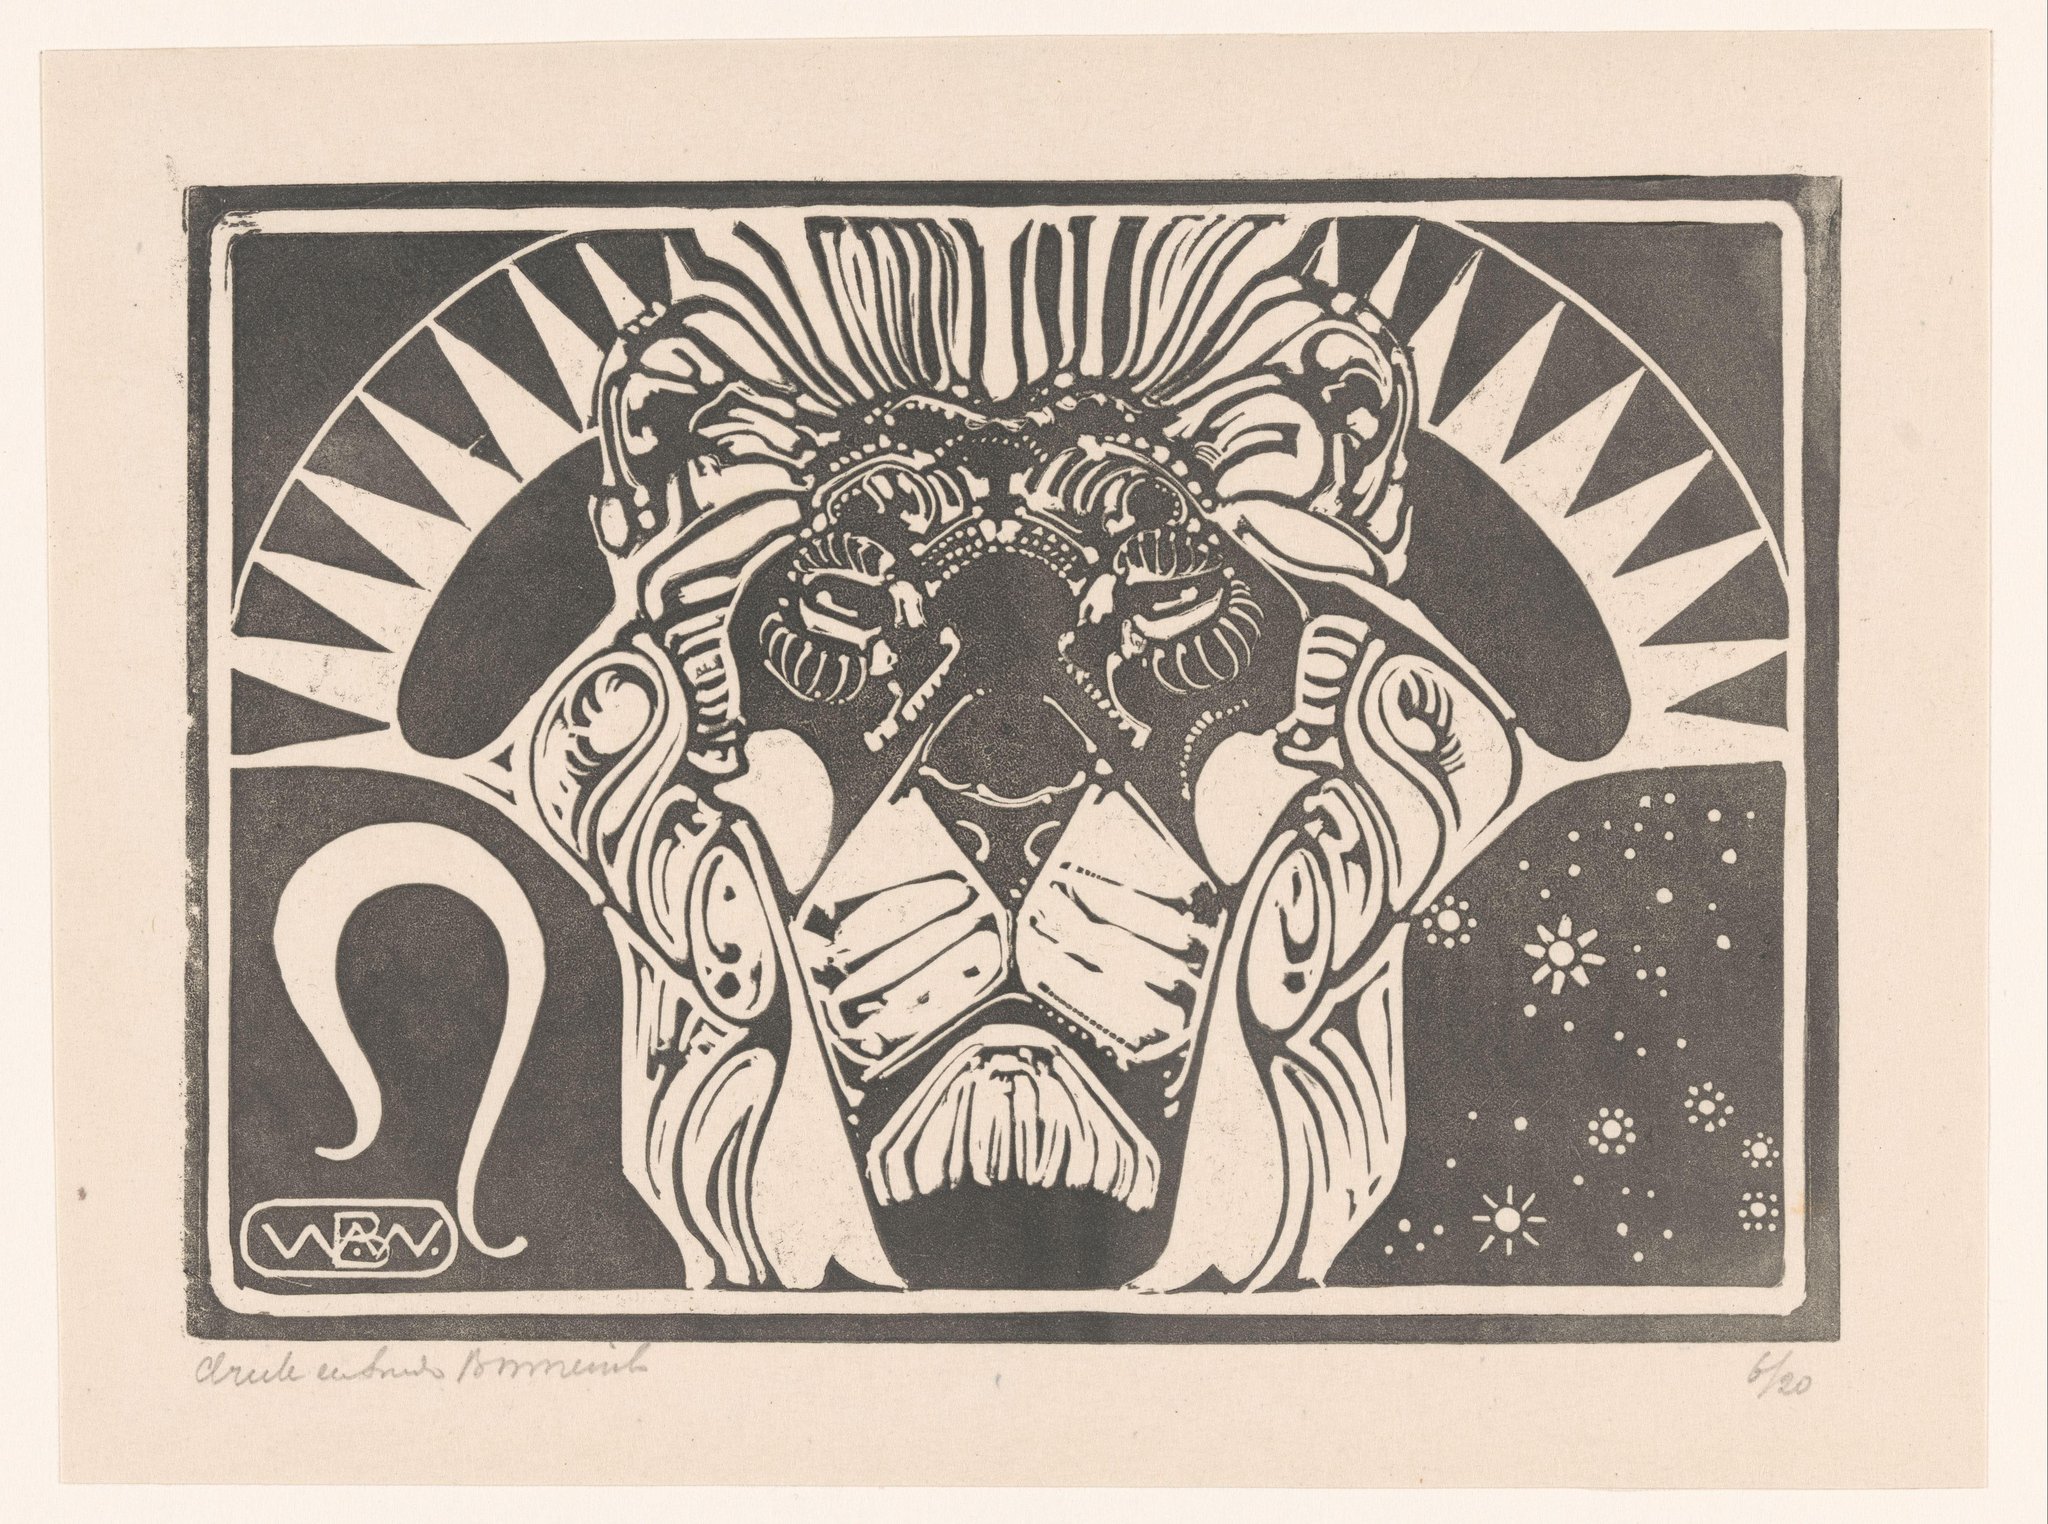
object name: print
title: Leo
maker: bernard willem wierink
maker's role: draughtsman, print maker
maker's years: 1856-1939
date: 1918-1919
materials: paper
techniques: relief print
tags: beasts of prey, predatory animals: lion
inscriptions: collector's mark: Lugt 2228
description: Deze prent is vermoedelijk een plaatsnede, ook al wordt in de literatuur veelal gesproken over een houtsnede. Voor zover Wierink zijn prenten in hoogdruk zelf nader heeft omschreven, heeft hij altijd de term 'plaatsnede' gebruikt.